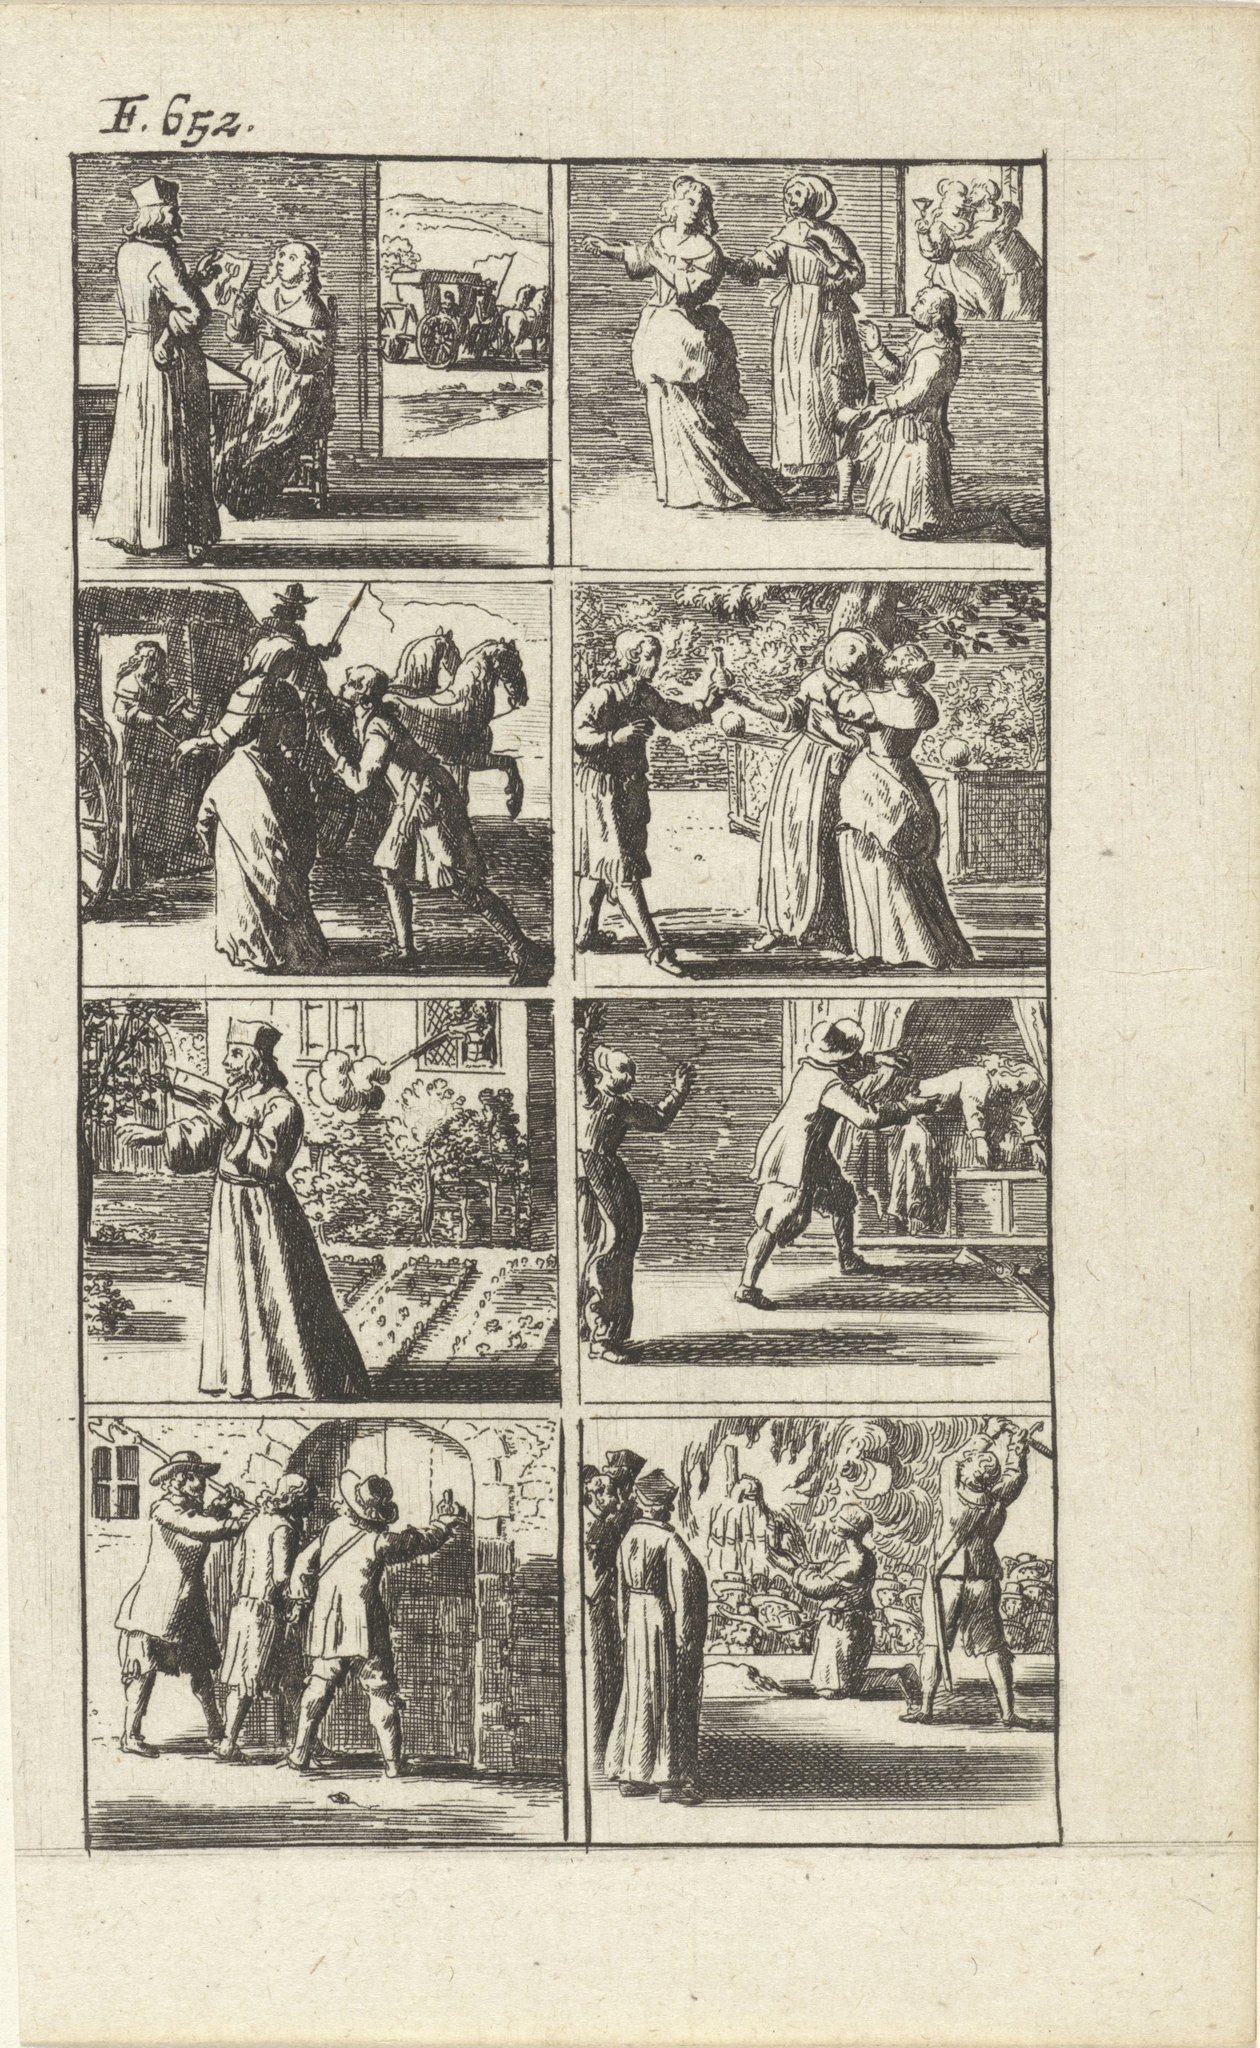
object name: print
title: Verhaal met voorstellingen van moord en doodstraf (F. 652.)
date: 1667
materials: paper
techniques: etching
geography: amsterdam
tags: death penalty, execution, murder, fighting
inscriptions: collector's mark: Lugt 2166, collector's mark: Lugt 2760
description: Verhaal in acht scènes met enkele voorstellingen van moord en doodstraf. Onder andere van een man die wordt neergeschoten en van een man die in zijn slaapkamer is vermoord. Rechtsonder wordt een man onthoofd en staat een onthoofd persoon op een brandstapel. Linksboven: F. 652.